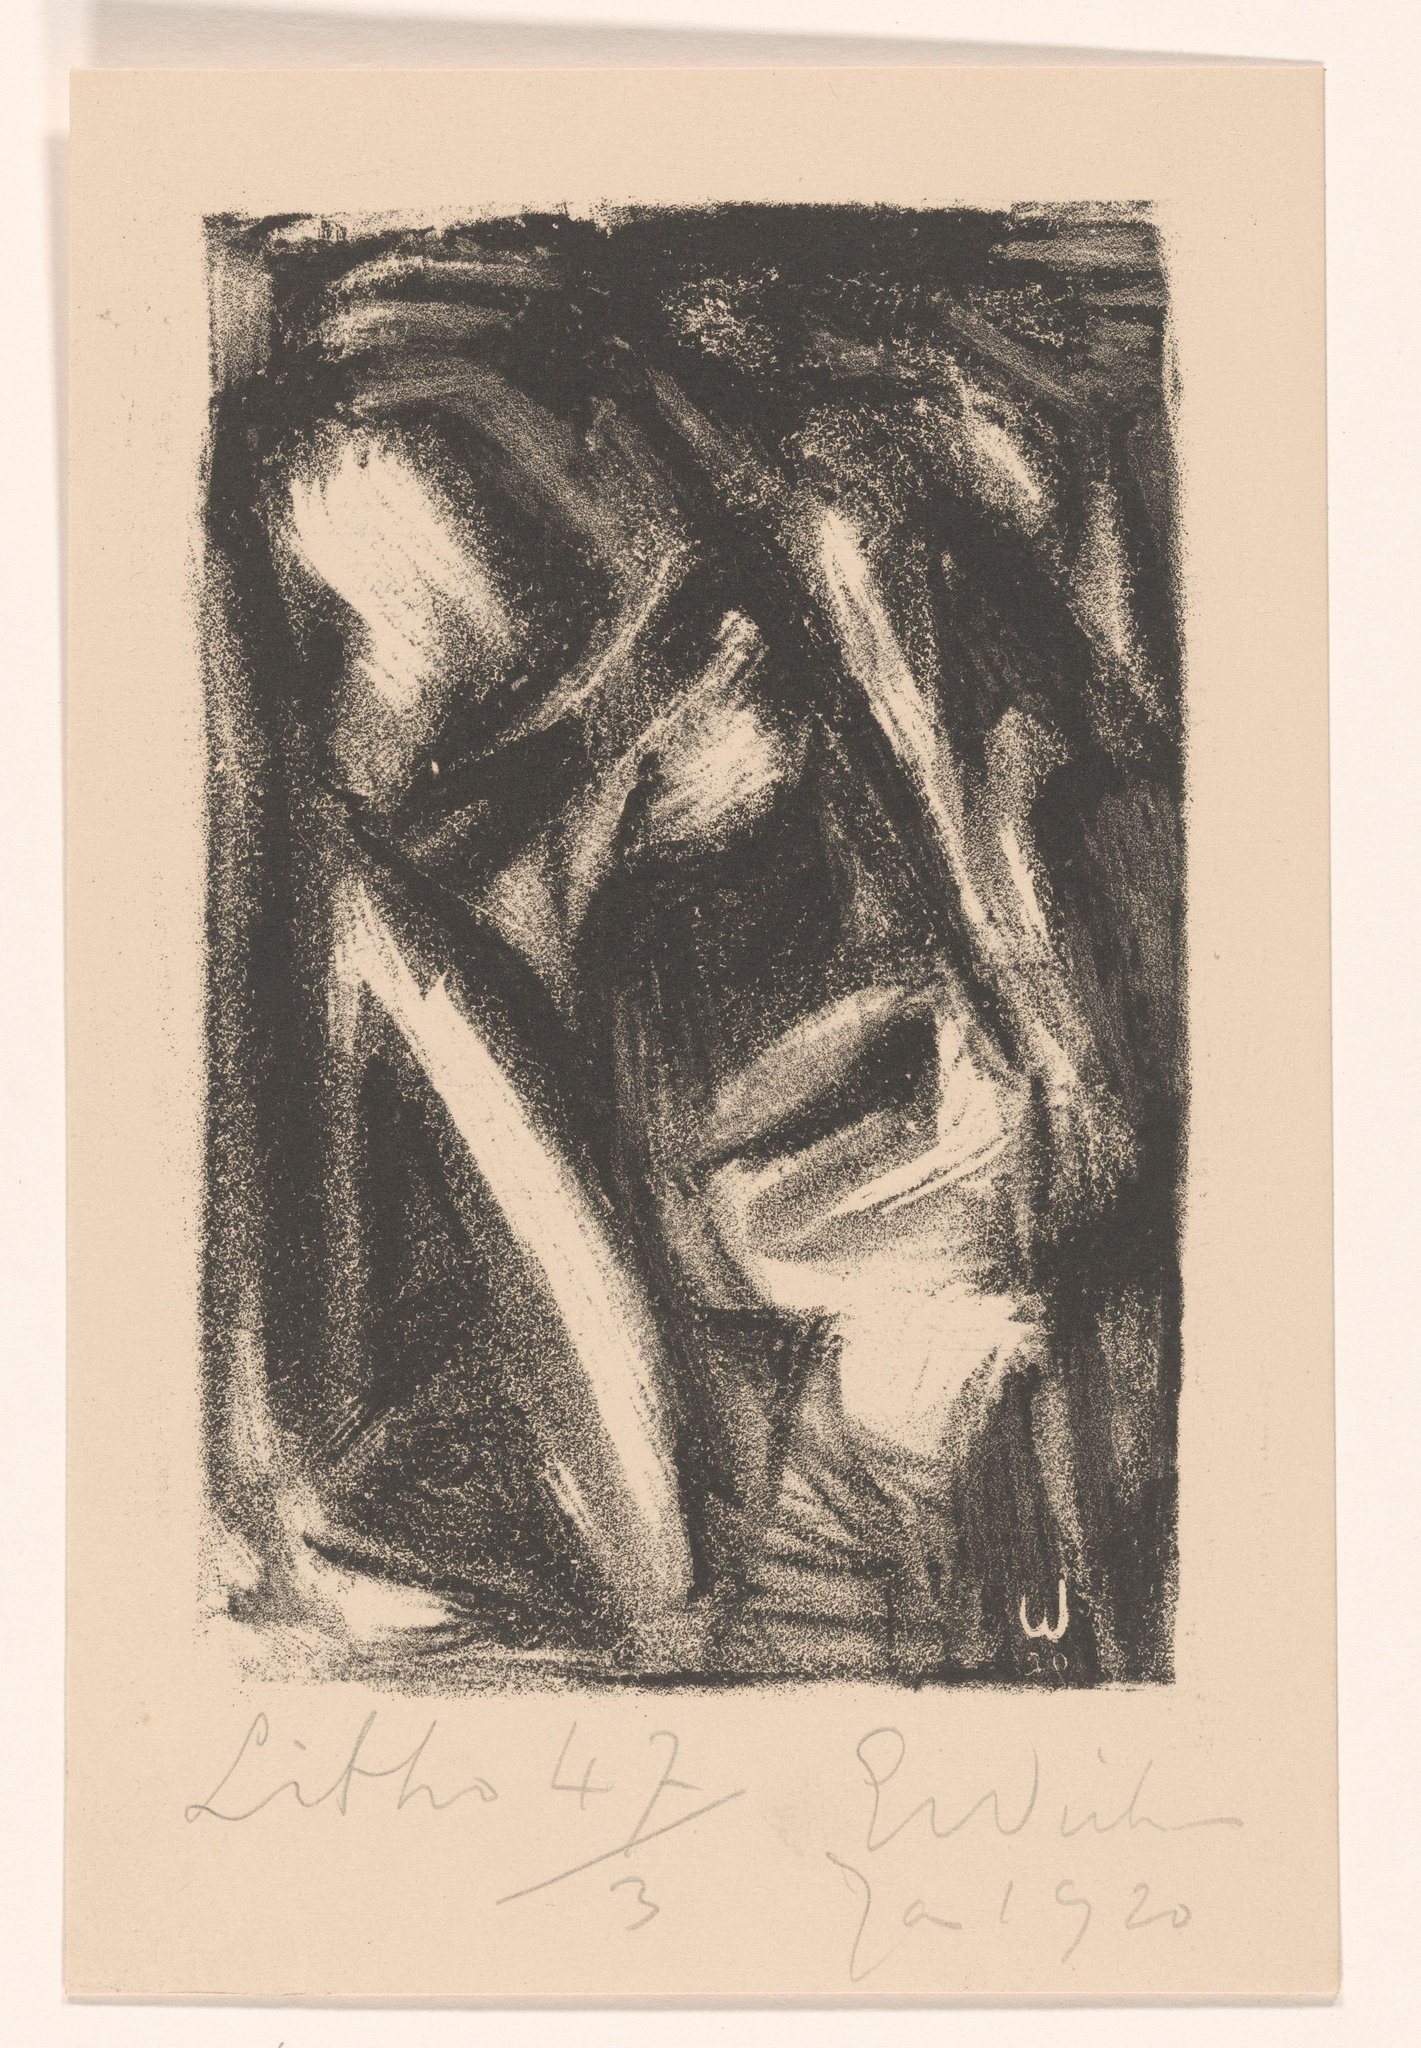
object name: print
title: Abstracte compositie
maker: erich wichmann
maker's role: print maker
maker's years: 1890-1929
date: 1920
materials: paper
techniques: lithograph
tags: abstract, non-representational art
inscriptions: collector's mark: Lugt 2228